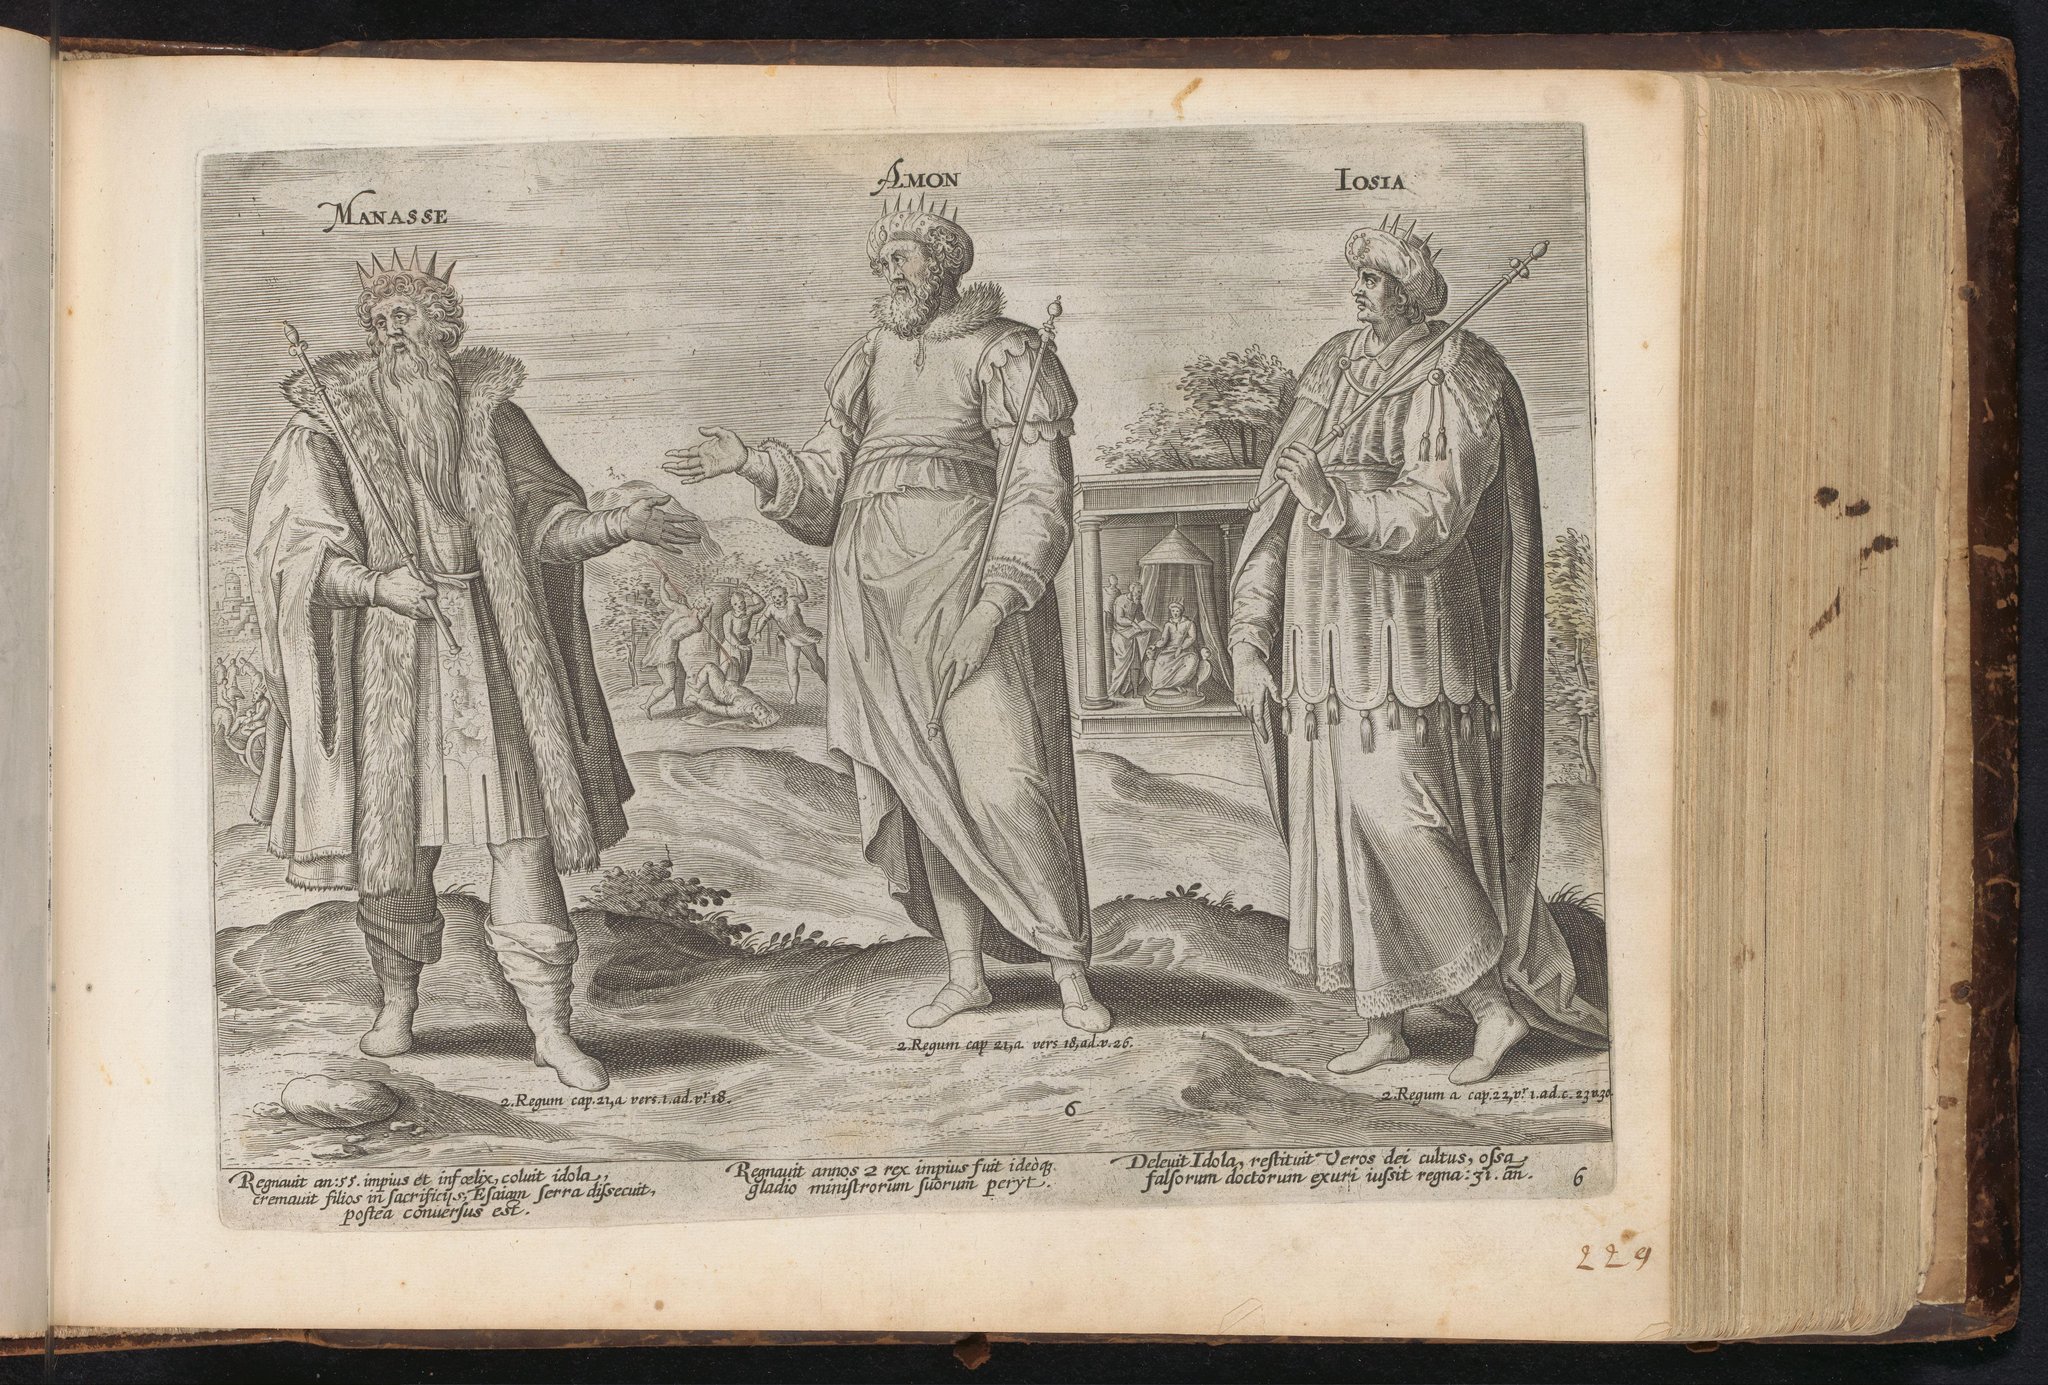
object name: album leaf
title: Manasse, Amon en Josia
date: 1585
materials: paper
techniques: engraving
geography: amsterdam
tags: story of manasseh, son of hezekiah, king of judah (2 kings 21:1-18; 2 chronicles 33:1-20), amon is killed in his palace (+ variant), story of josiah, son of amon, king of judah (2 kings 22:1 - 23:30; 2 chronicles 34-35), story of amon, son of manasseh, king of judah (2 kings 21:19-26; 2 chronicles 33:21-25), saphan reads the book of law aloud to the king who tears his clothes in dismay, kings of israel and judah ~ the old testament (not in biblical context)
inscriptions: number: ‘229’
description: De koningen Manasse, Amon en Josia. Op de achtergrond enkele belangrijke gebeurtenissen uit hun leven. Links op de achtergrond zit koning Manasse in zijn strijdwagen. Midden op de achtergrond de moord op Amon door zijn eigen dienaren. Rechts op de achtergrond laat koning Josia zich voorlezen uit een boekrol die in de tempel werd gevonden. Onder de voorstelling verwijzingen naar de Bijbelteksten in het Latijn. Deze prent maakt deel uit van een album.